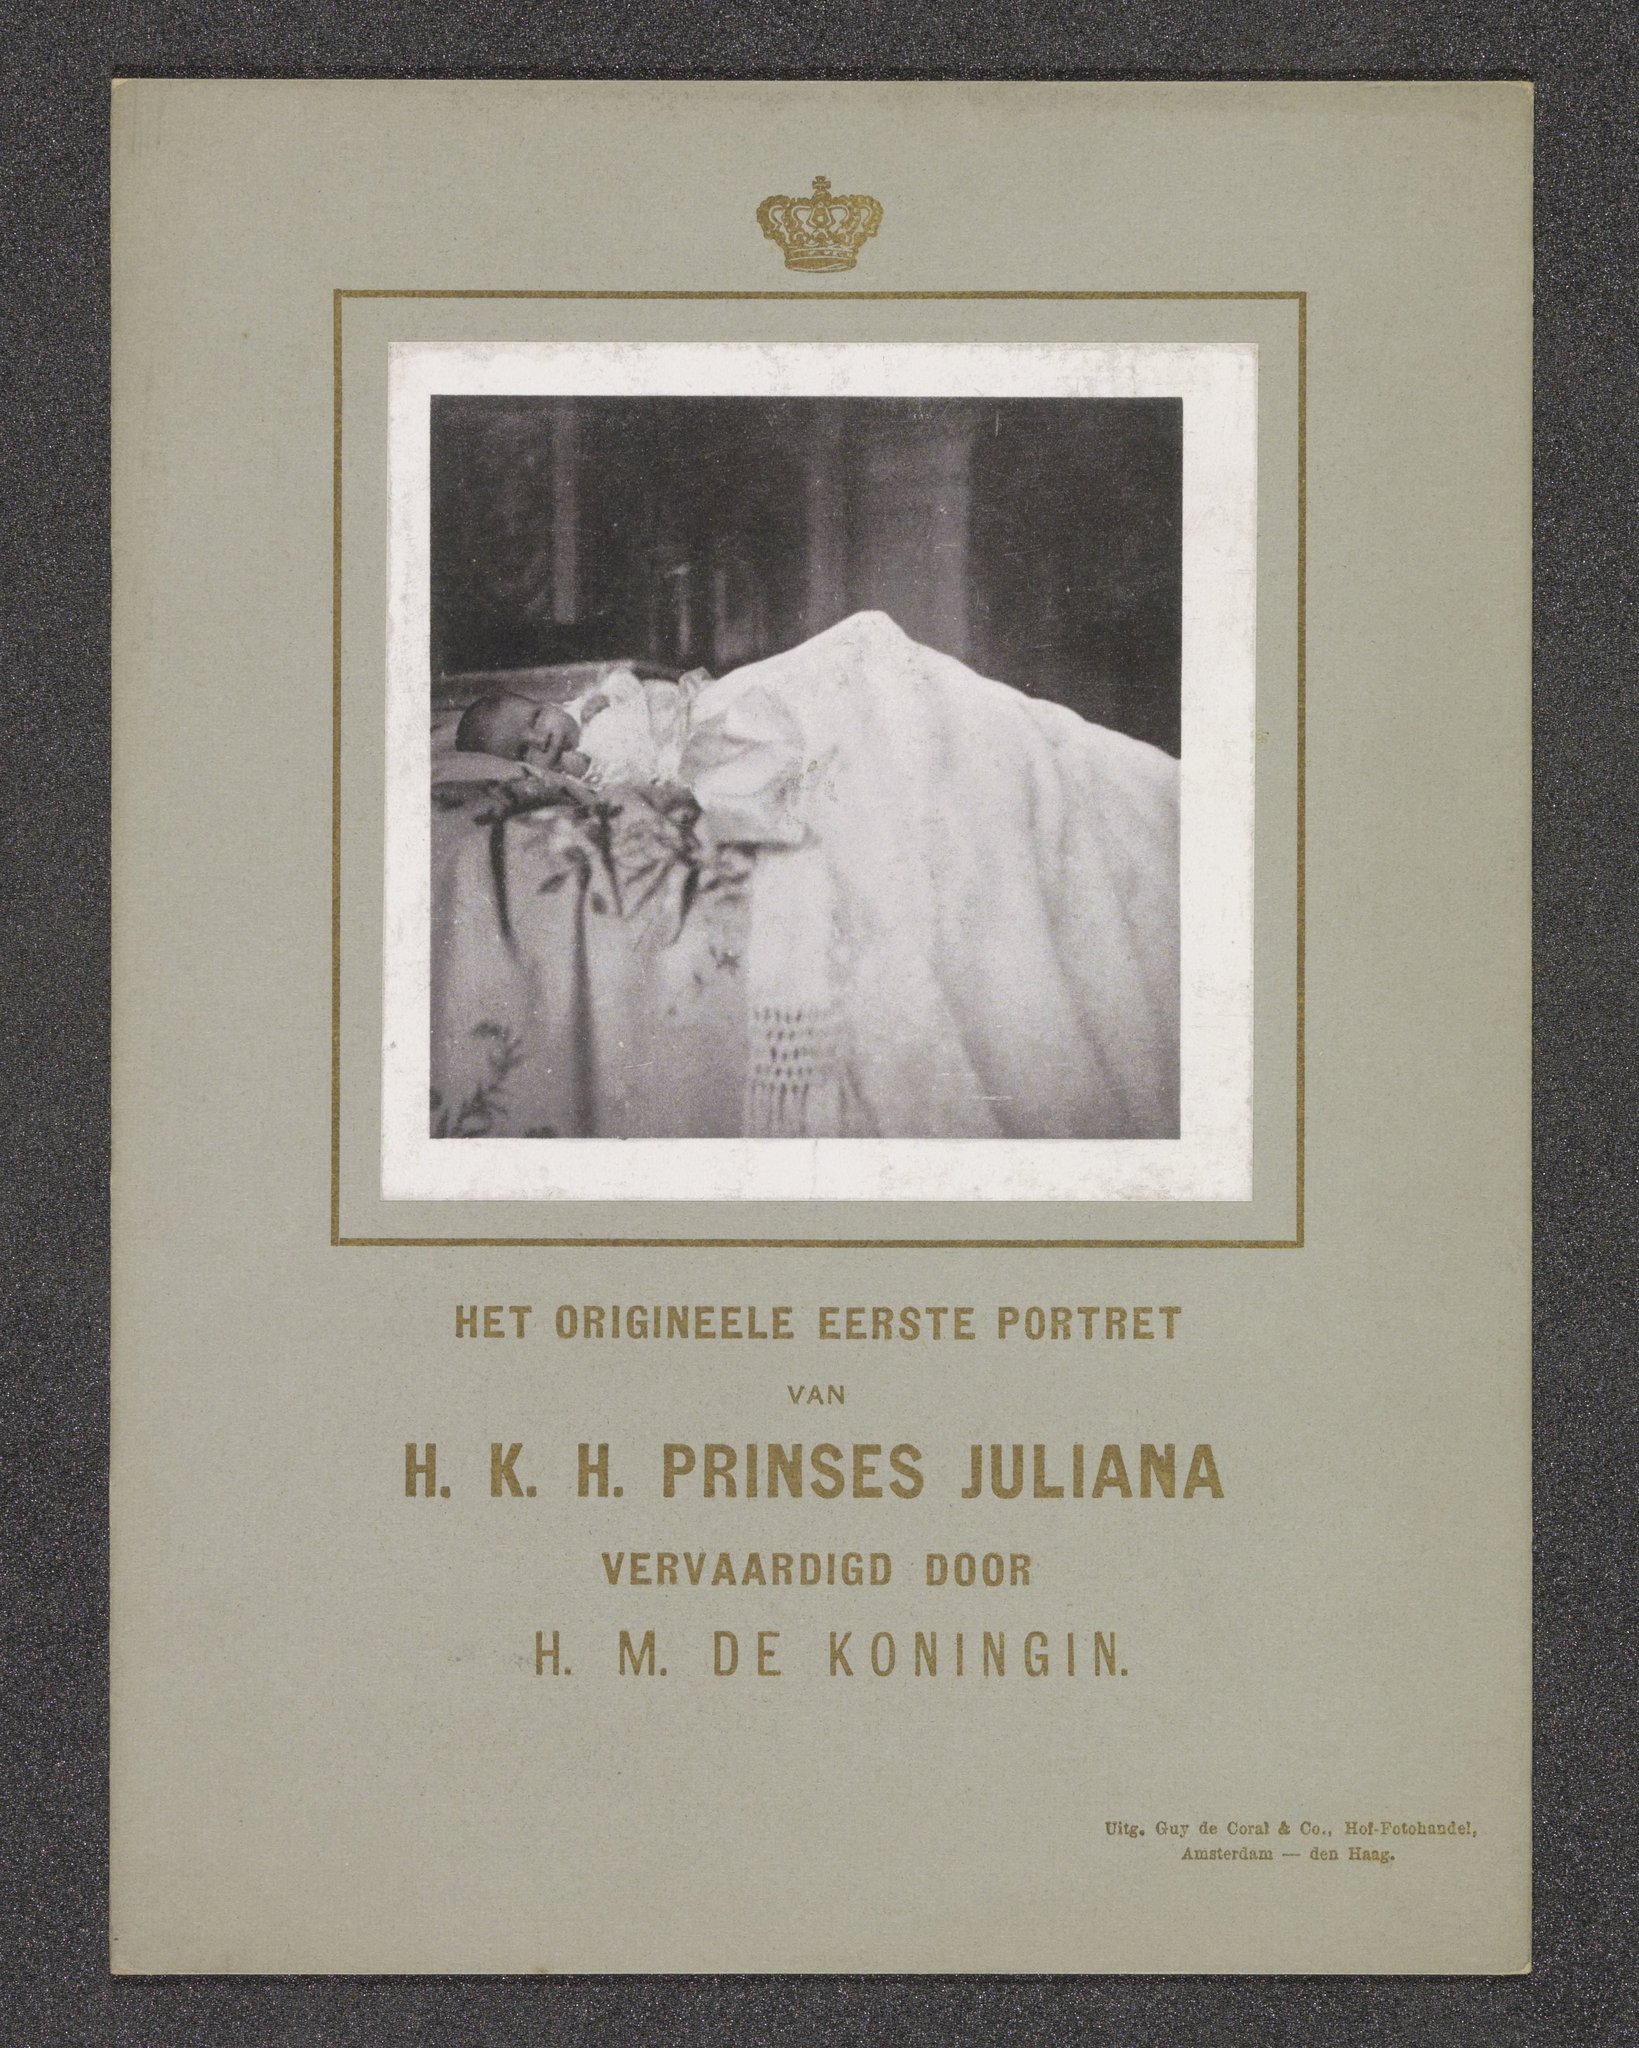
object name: photograph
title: Babyportret van prinses Juliana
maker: wilhelmina of the netherlands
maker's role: print maker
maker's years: 1880-1962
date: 1909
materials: cardboard, paper, photographic support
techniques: photograph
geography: the hague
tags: juliana of the netherlands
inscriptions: annotation: ‘Het origineele eerste portret van H.K.H. Prinses Juliana vervaardigd door H.M. de Koningin’, name: ‘Uitg. Guy de Coral & Co,, Hof-Fotohandel, Amsterdam - den Haag’